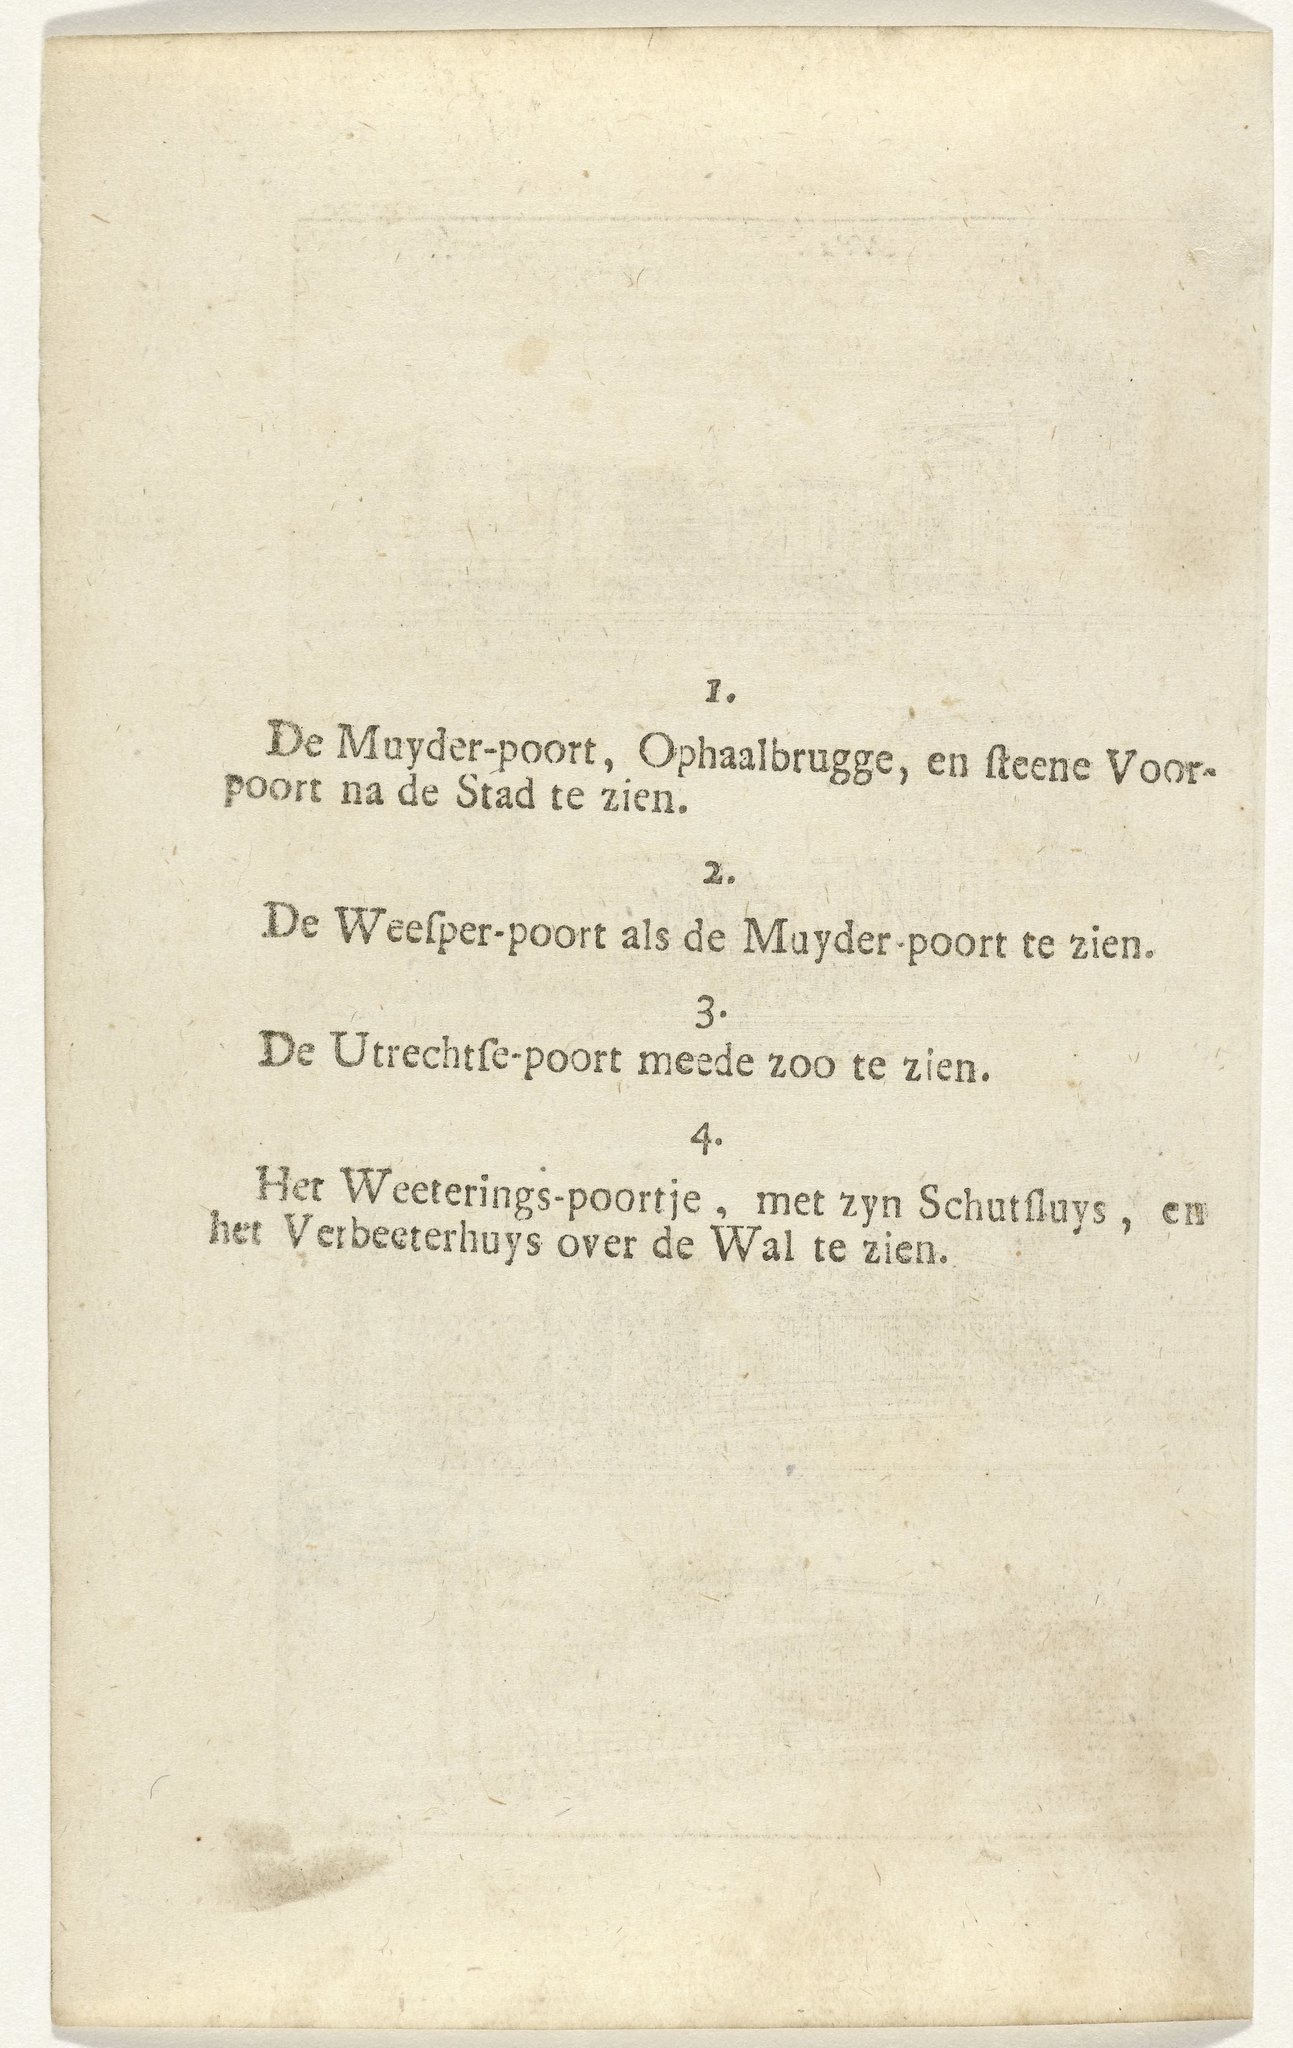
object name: text sheet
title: Tekstblad bij boekillustratie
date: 1723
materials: paper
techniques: letterpress printing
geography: amsterdam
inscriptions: collector's mark: Lugt 2228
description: Tekstblad uit: Leuve, Roeland van. 's Waerelds koopslot of De Amsteldamse beurs. Amsterdam: Jacobus Verheyden (I), 1723.